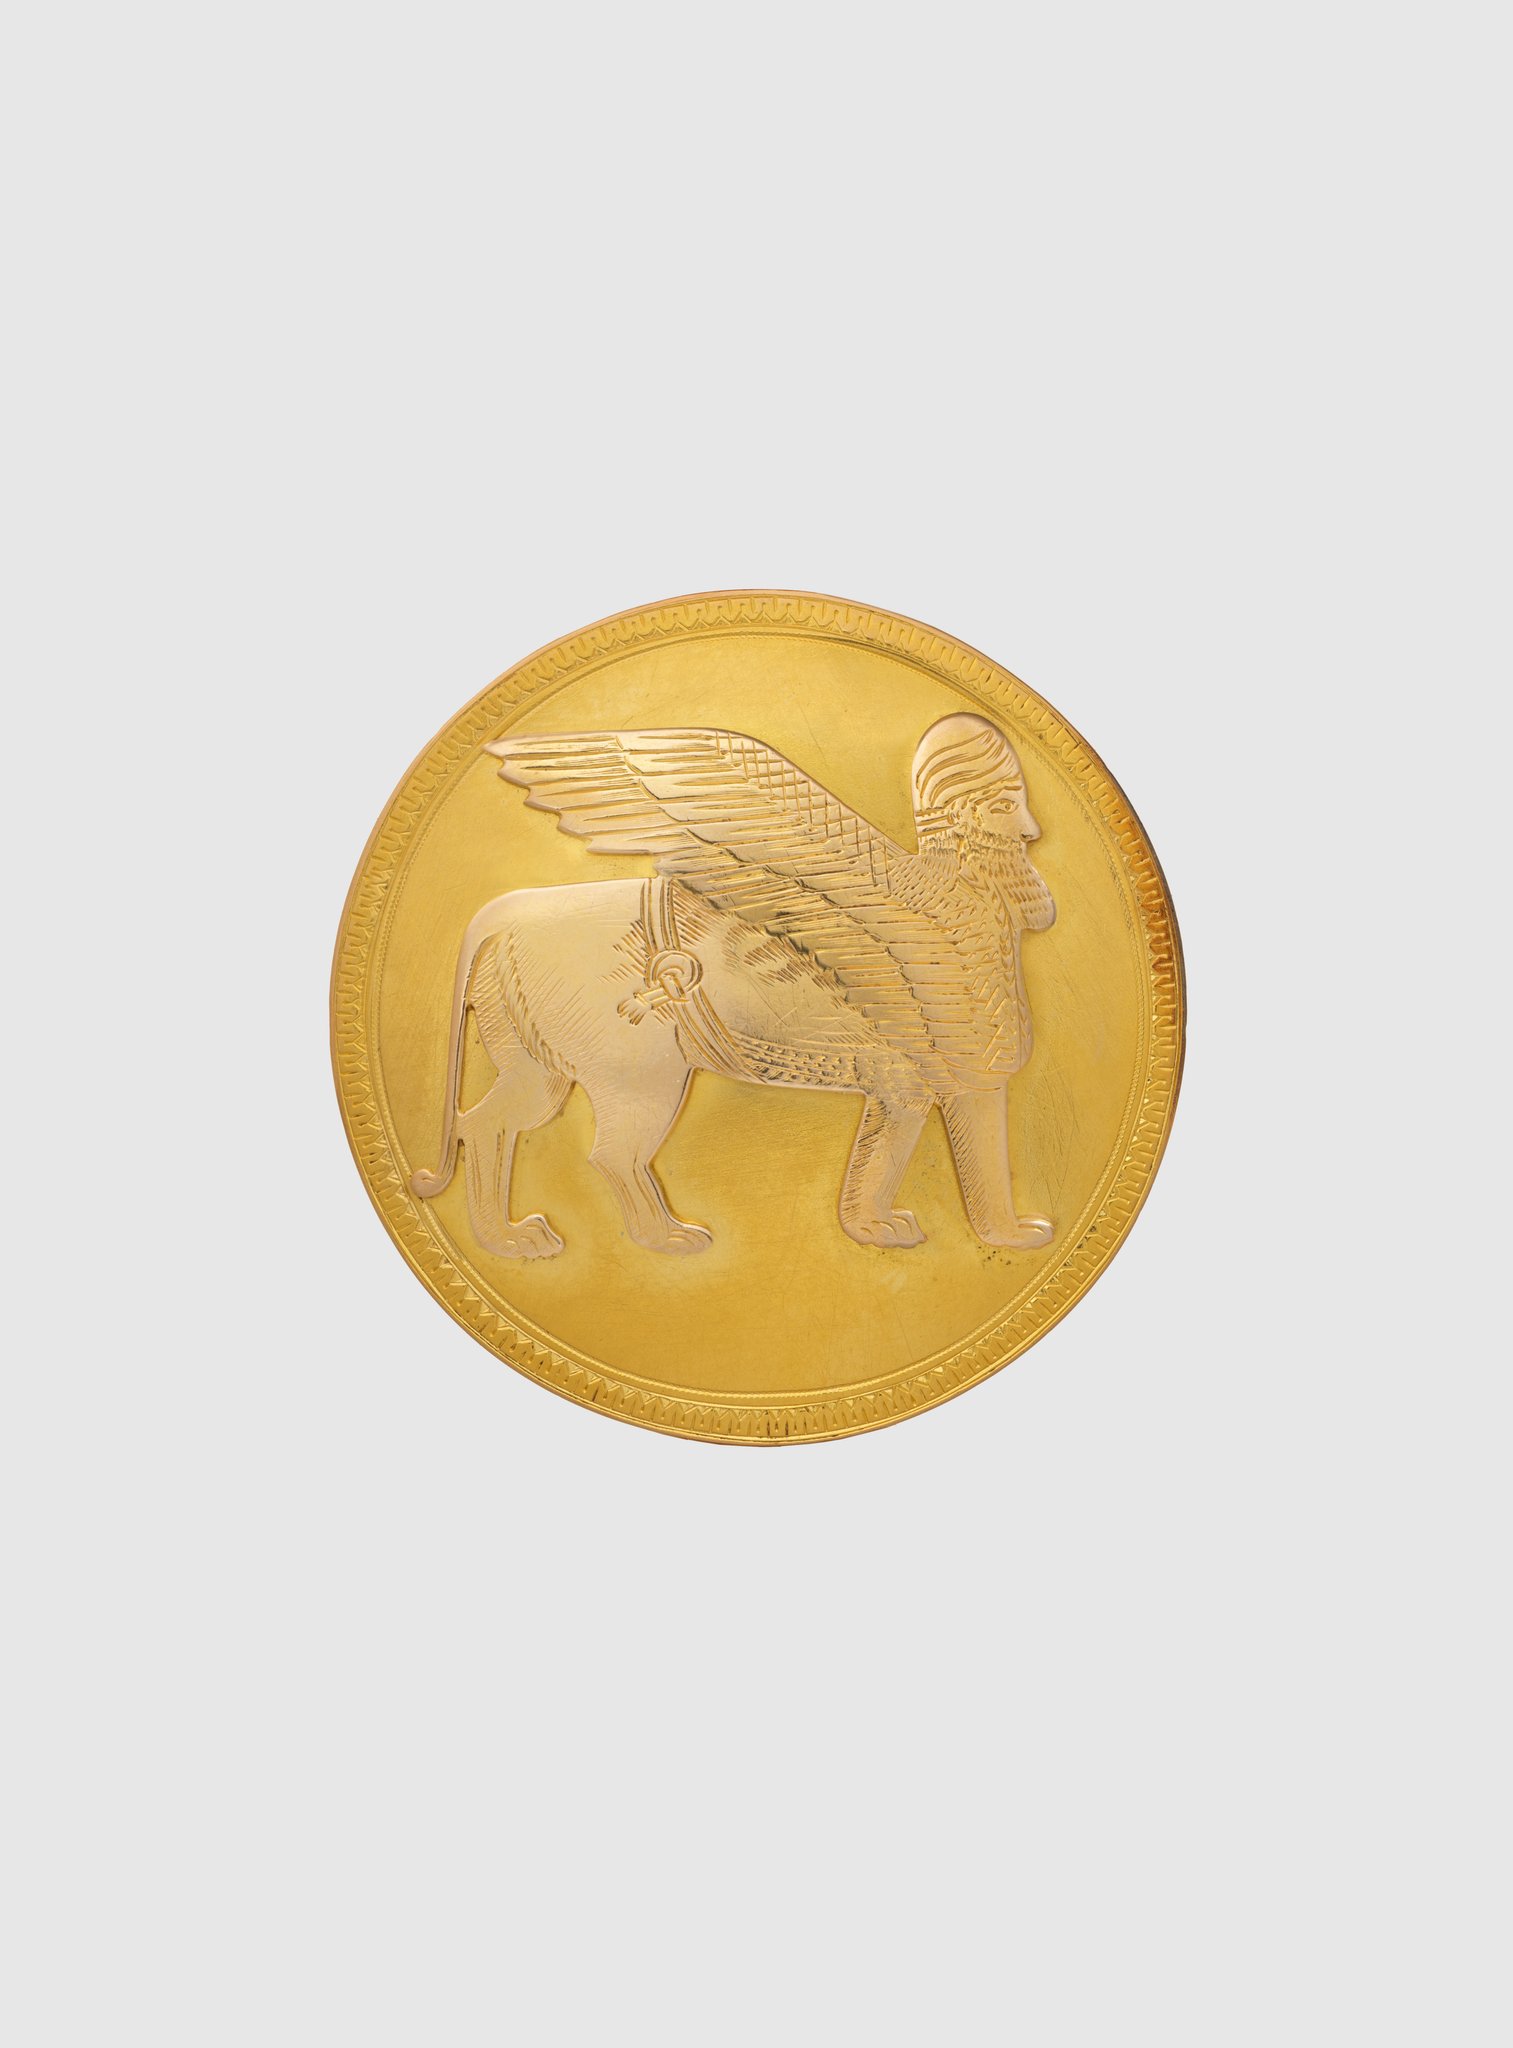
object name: brooch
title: Brooch with Assyrian human-headed winged lion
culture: british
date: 1851-1900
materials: glass, gold, paper